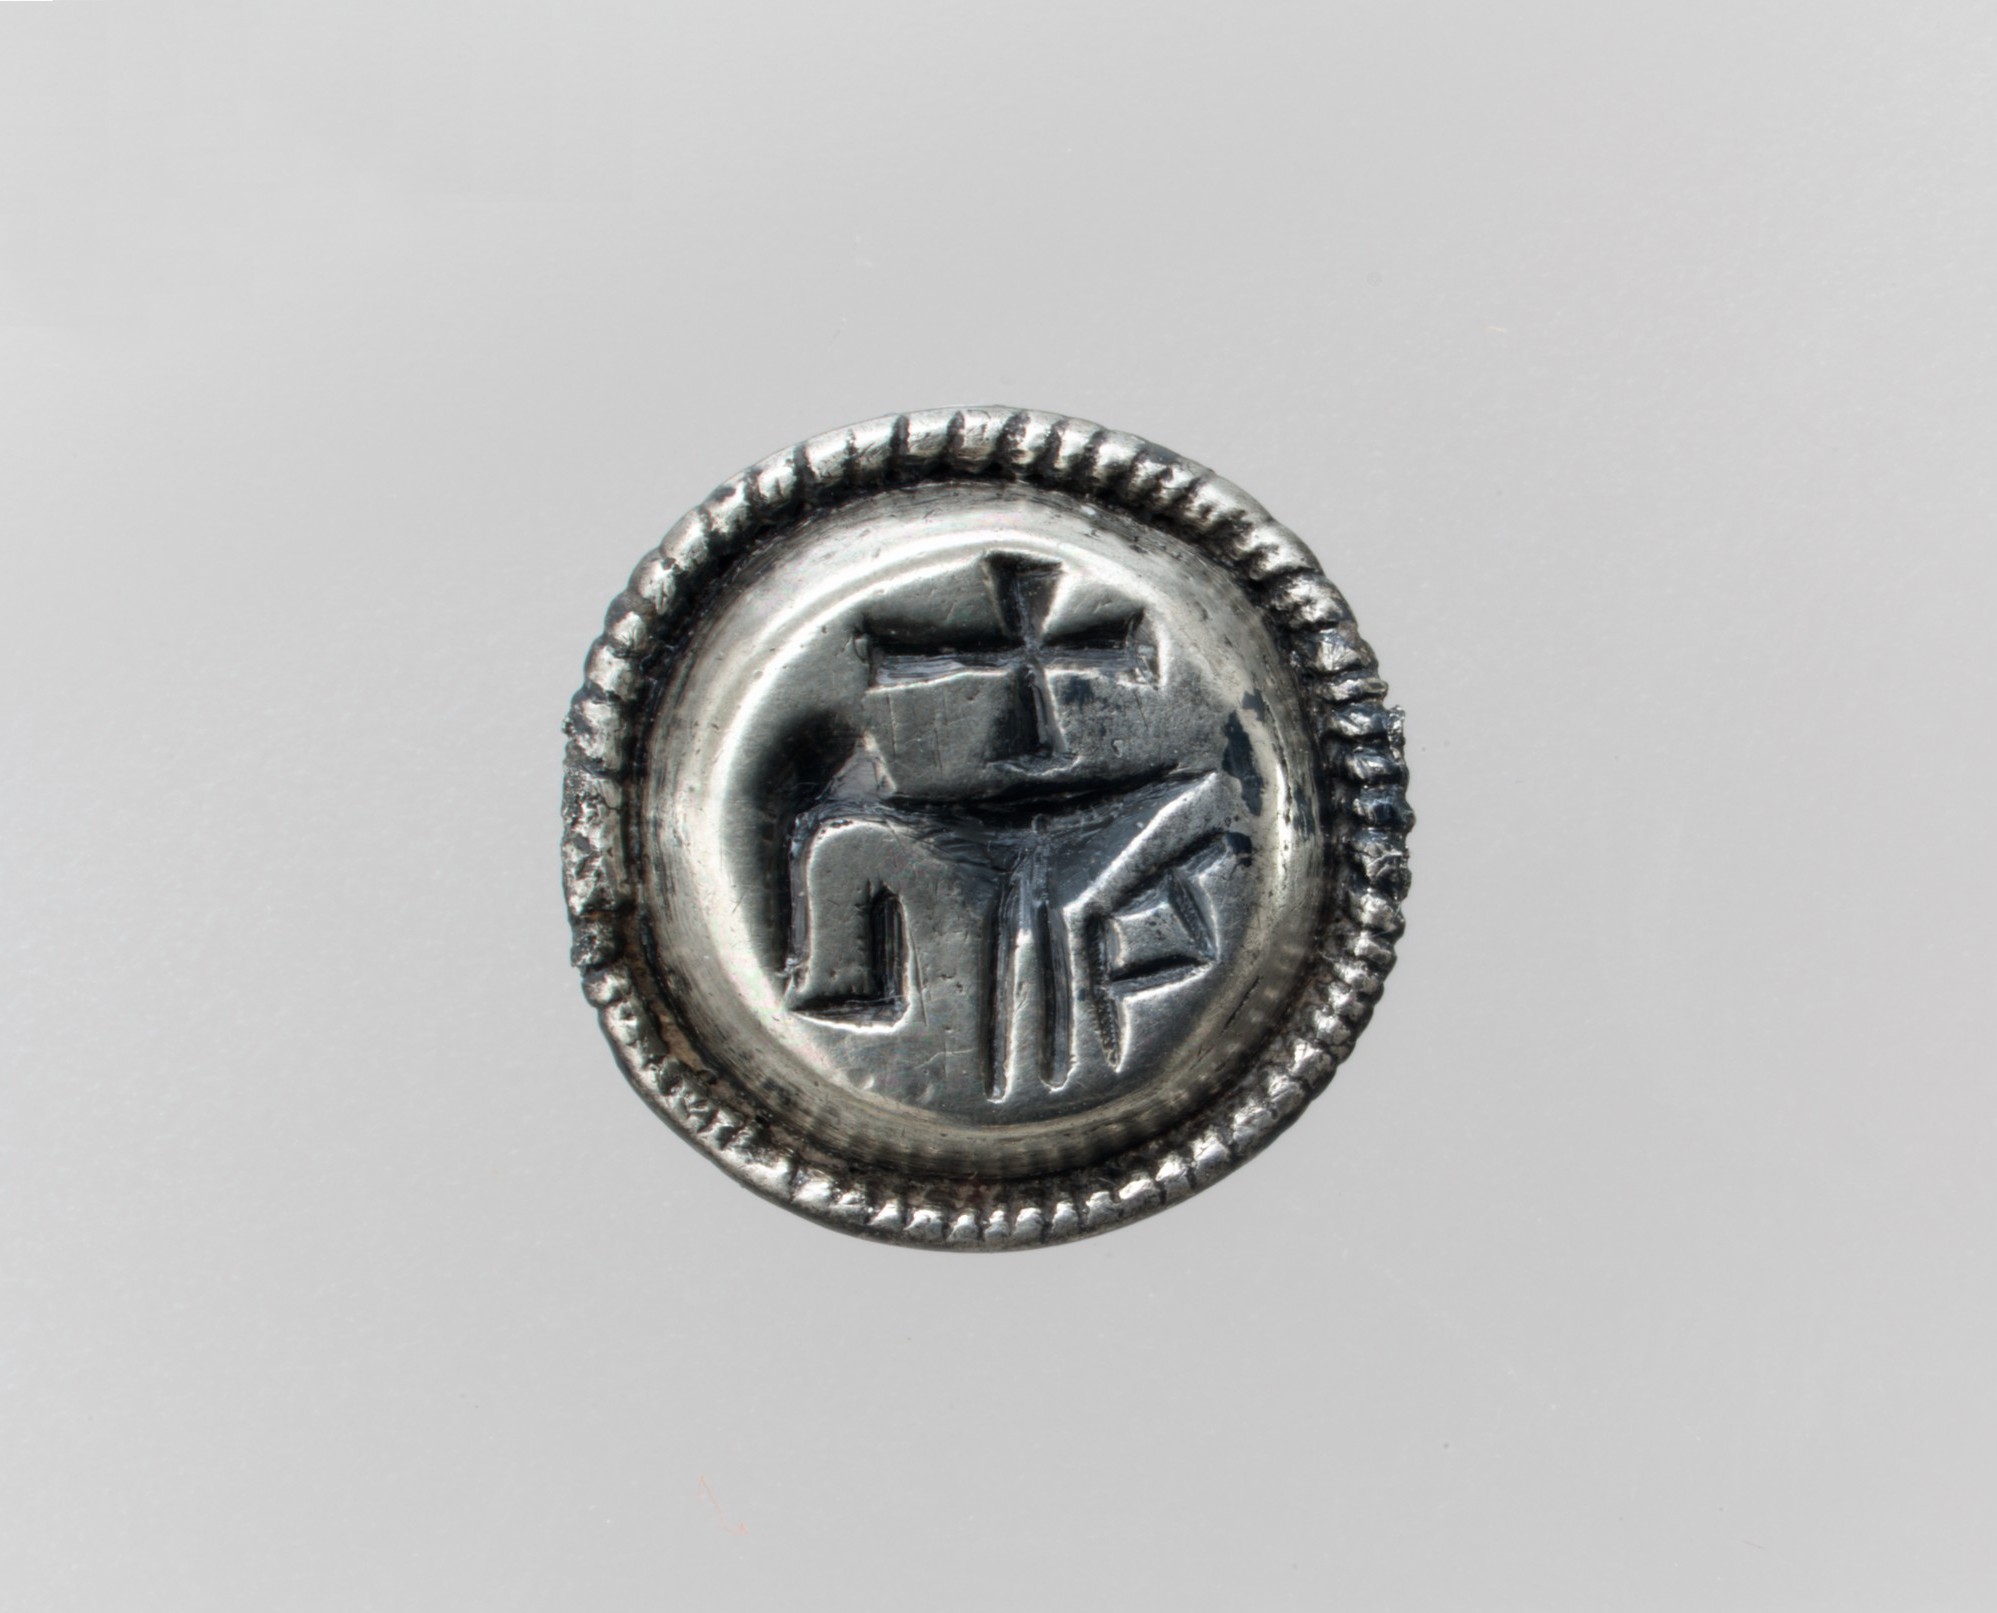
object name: bezel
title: Top of a Signet Ring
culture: frankish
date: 601-700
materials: silver gilt, metal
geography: france